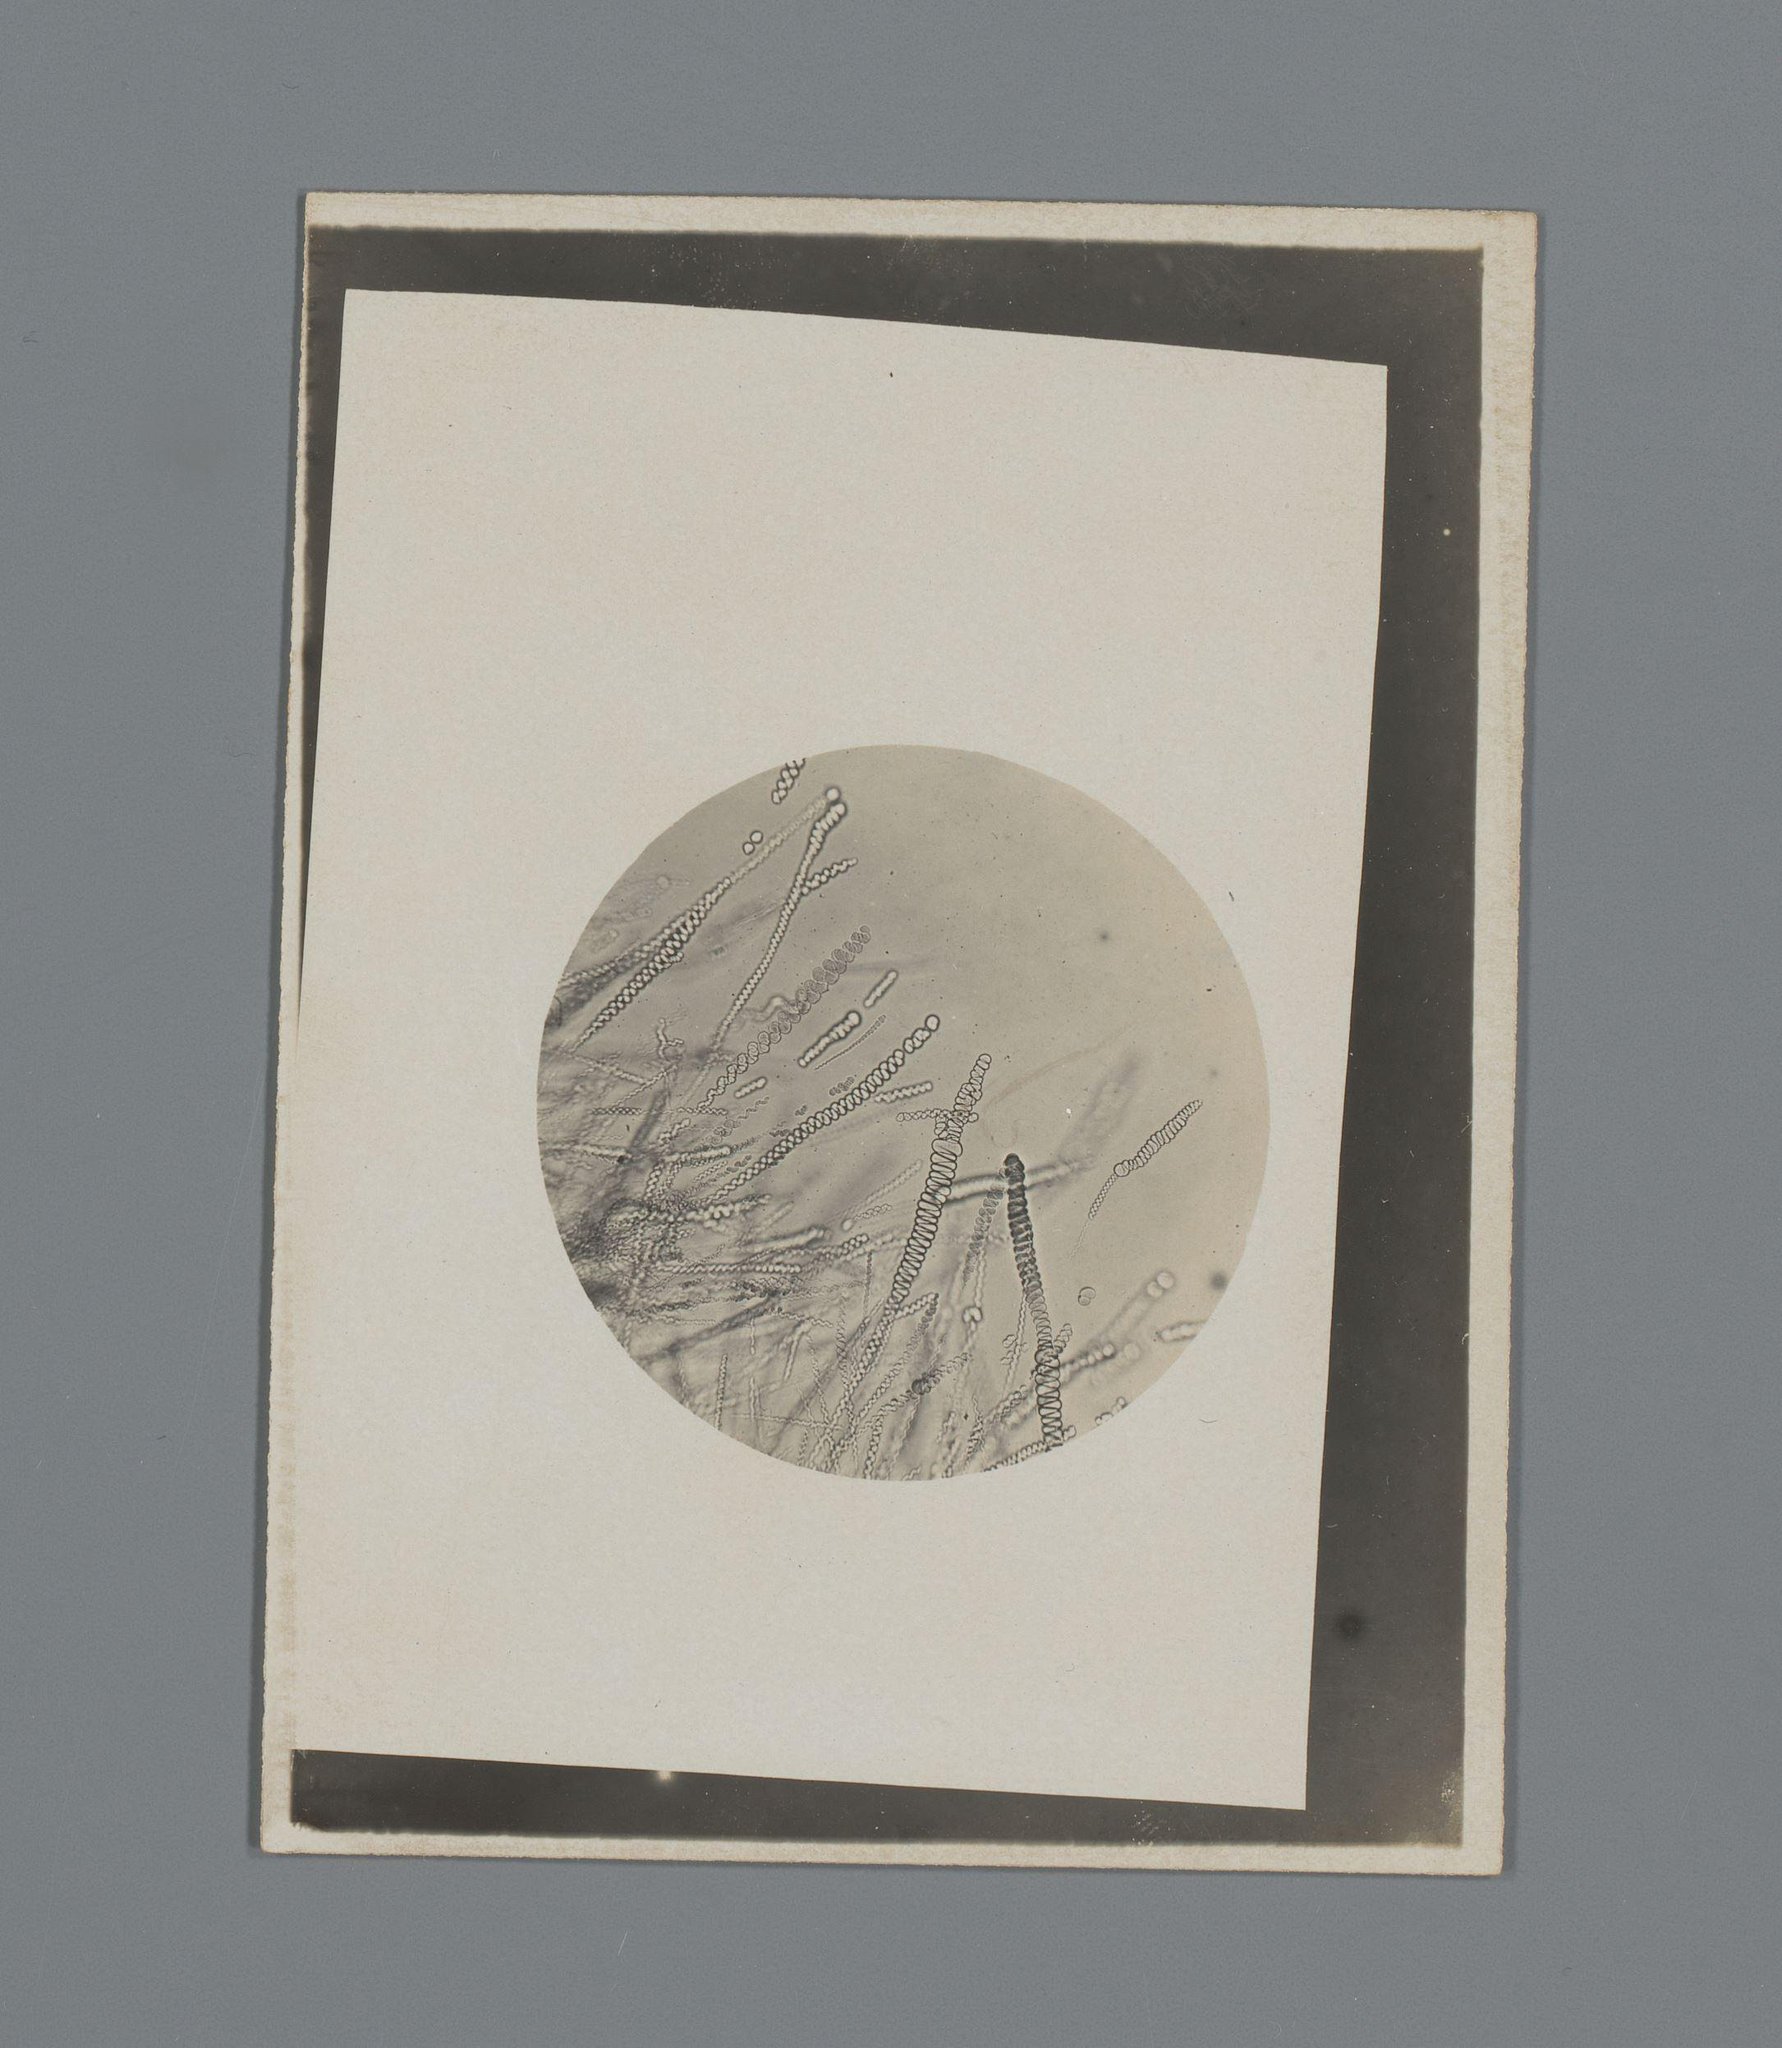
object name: photograph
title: Opname van een microscopisch preparaat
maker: Anonymous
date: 1880-1910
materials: paper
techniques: gelatin silver print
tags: unicellular animals, bacteria, bacilli